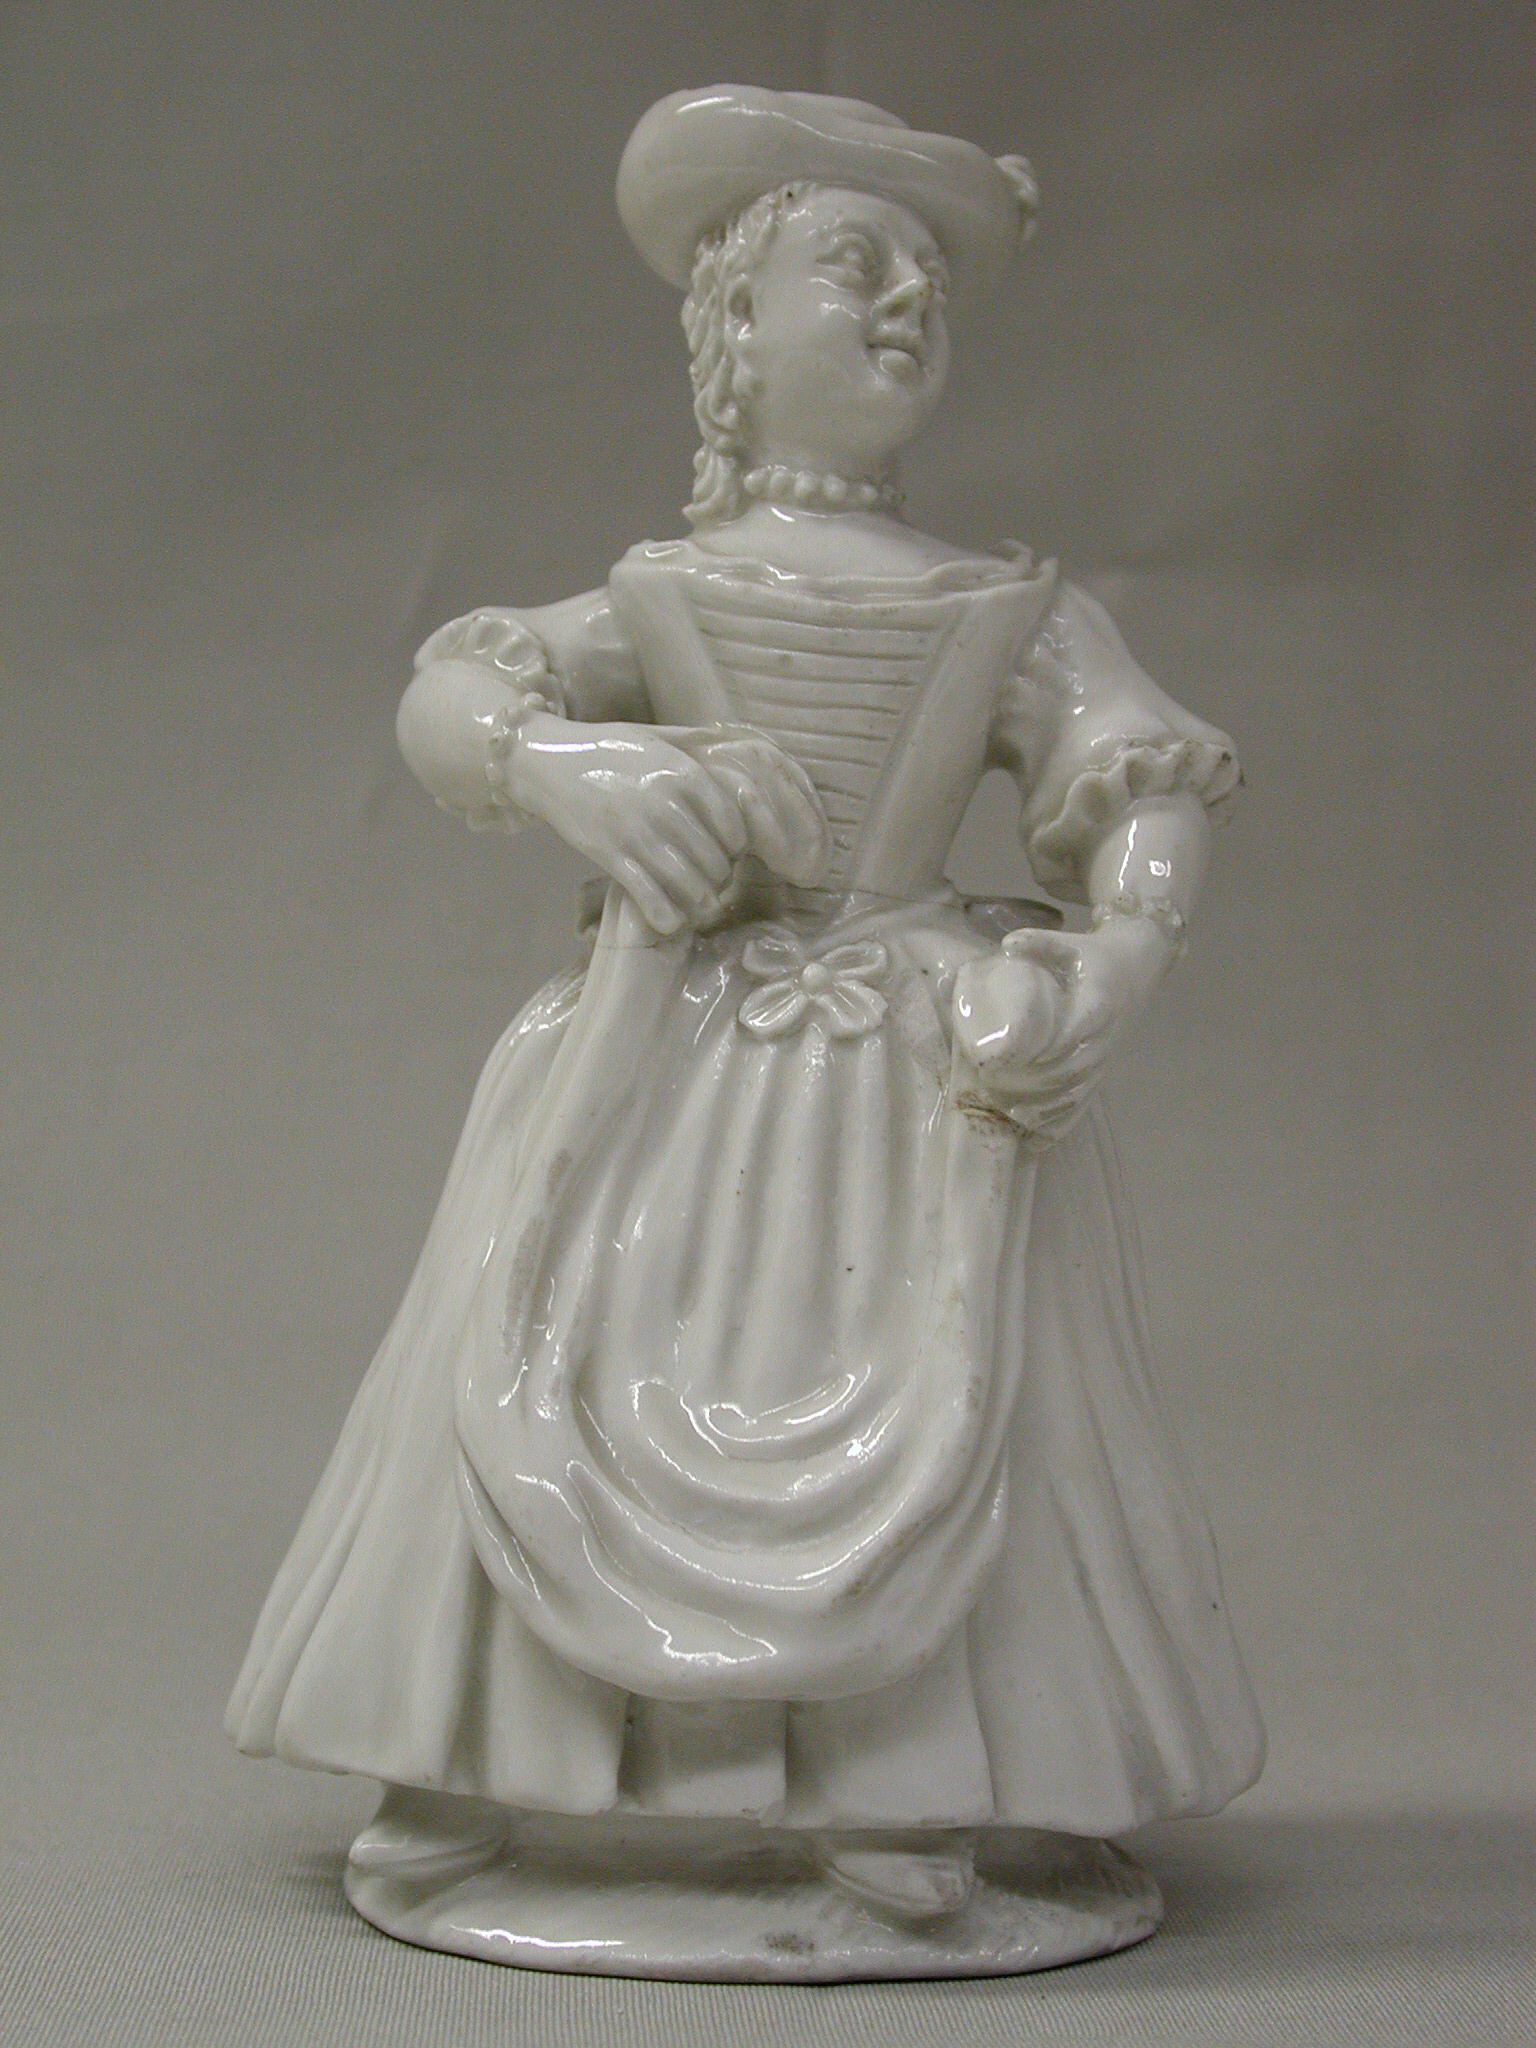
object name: figure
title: Woman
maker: vienna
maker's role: manufactory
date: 1740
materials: hard paste porcelain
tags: women